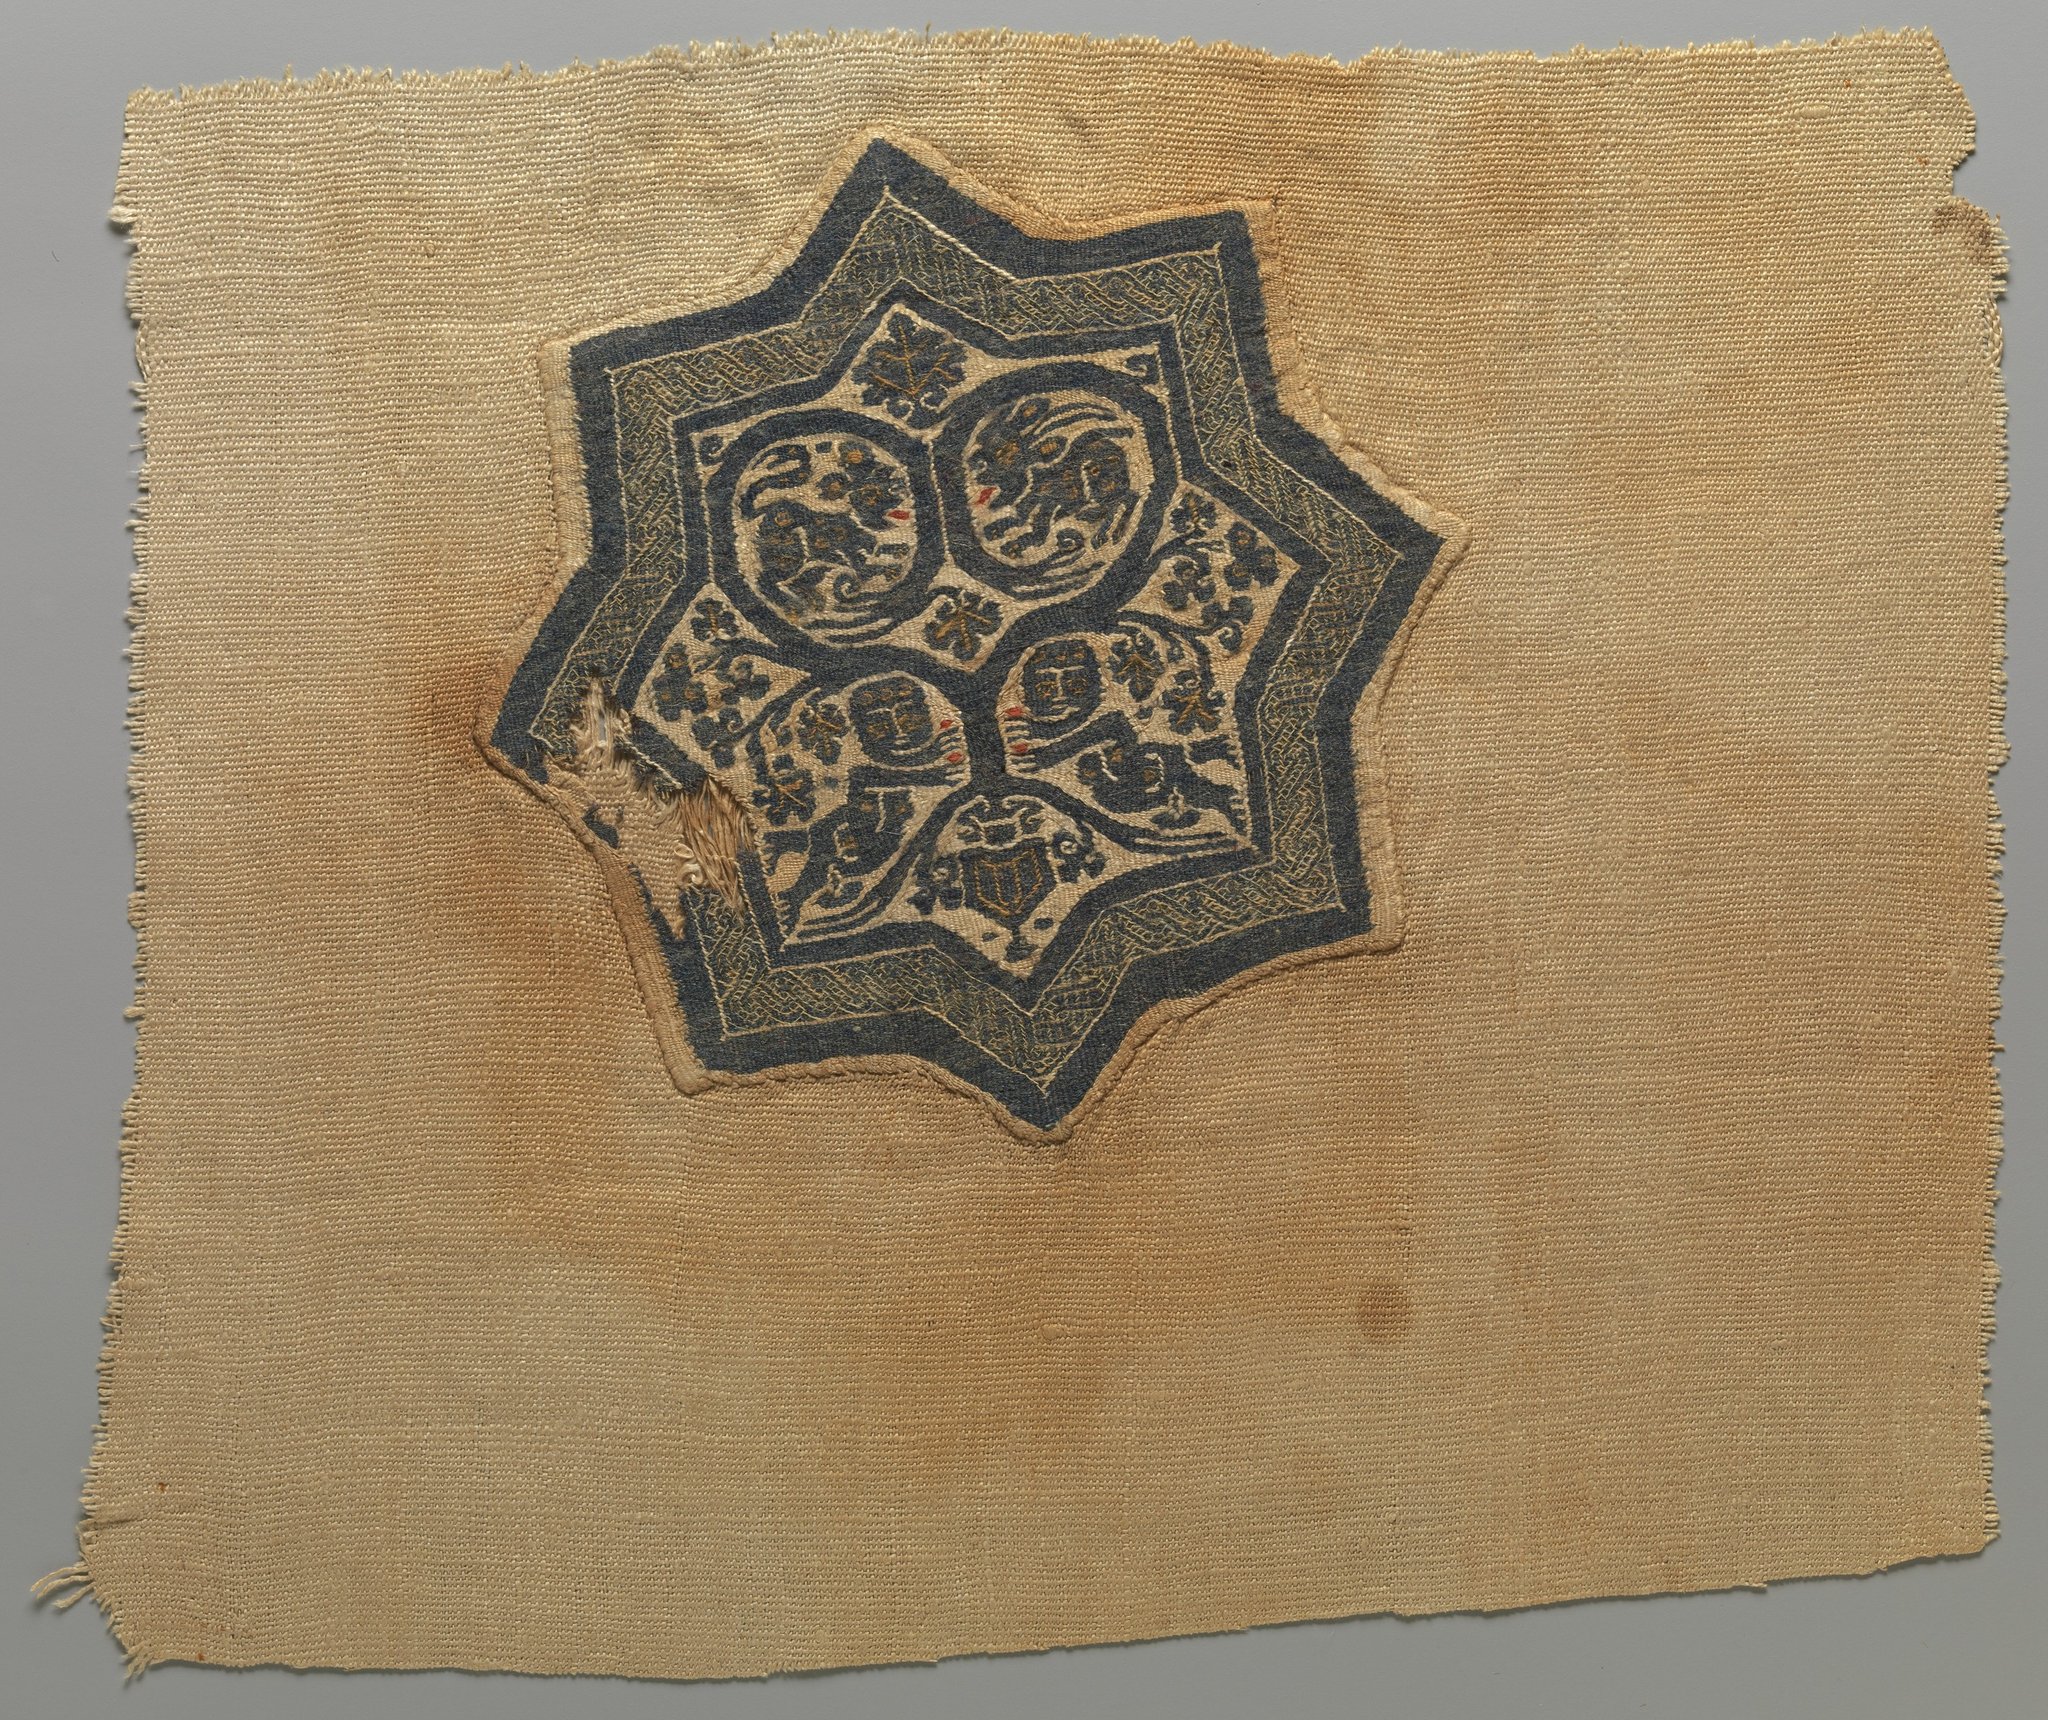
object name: textile fragment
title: Textile Fragment with Inhabited Vine in an Eight-Pointed Star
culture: coptic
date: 401-600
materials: linen, wool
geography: egypt